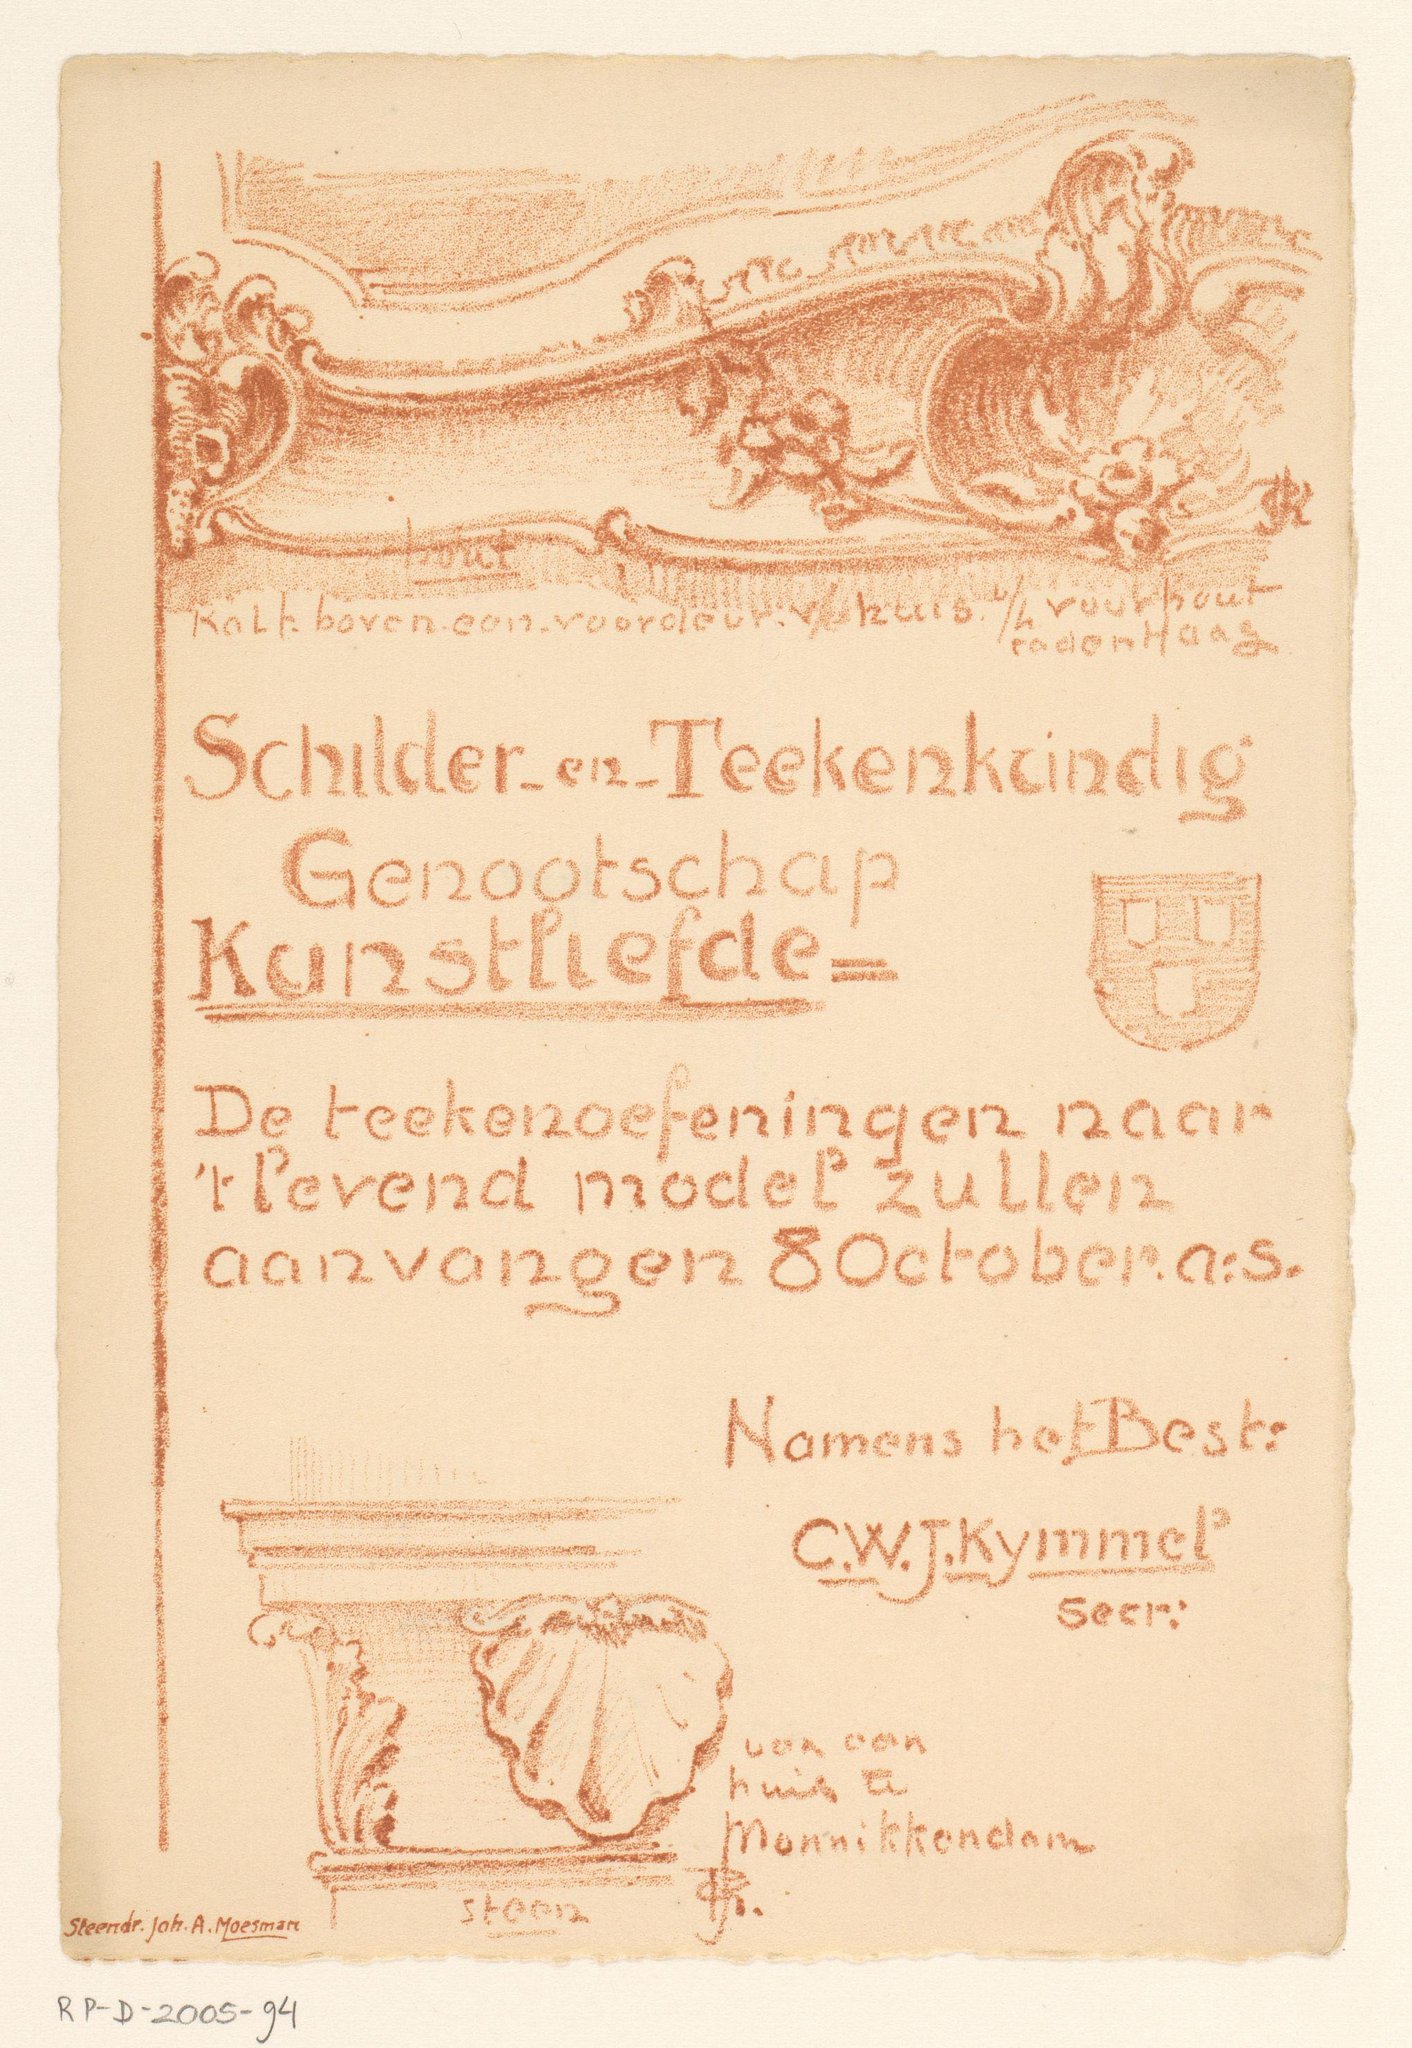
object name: invitation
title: Uitnodiging van Schilder- en Teekenkundig Genootschap "Kunstliefde" voor 'teekenoefeningen naar 't levend model' op 8 oktober 1900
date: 1900-1910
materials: paper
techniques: lithograph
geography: utrecht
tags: criticizing and discussing art, art criticism, circle, club of artists, collecting and exhibiting products of the fine arts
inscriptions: collector's mark: Lugt 2228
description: Architecturale details. Uitnodiging van Schilder- en Teekenkundig Genootschap "Kunstliefde" voor modeltekenen op 8 oktober 1900.